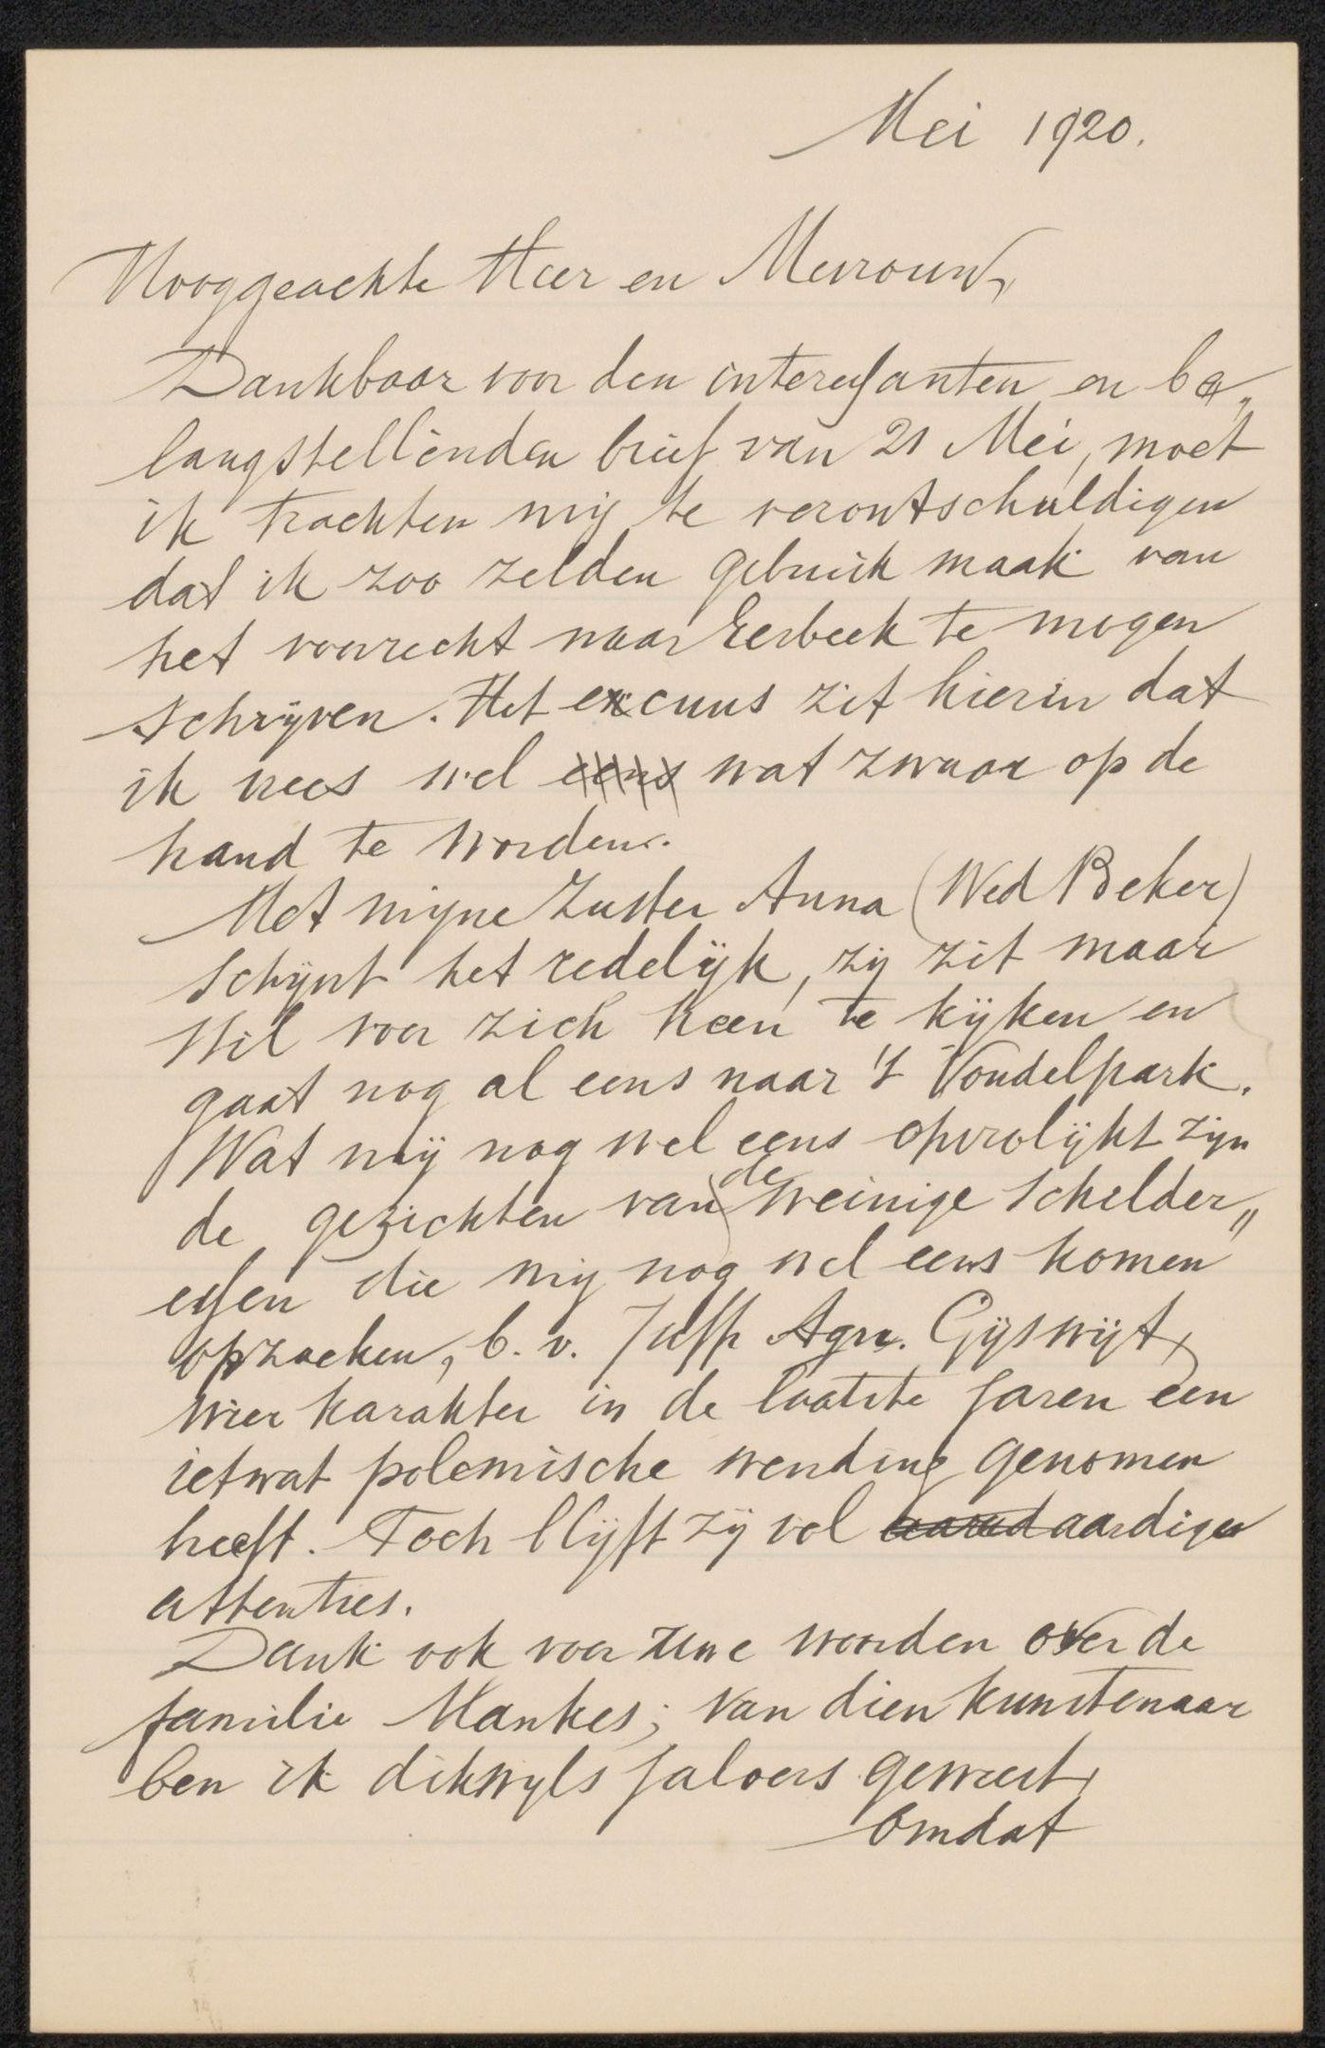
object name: letter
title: Brief aan Max Wilhelm Carl Weber en Anne Antoinette Weber-Van Bosse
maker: august allebé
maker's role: draughtsman, print maker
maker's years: 1838-1927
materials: ink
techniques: pen, writing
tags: anne antoinette weber-van bosse, amsterdam, painter, print maker, draughtsman, agnieta cornelia gijswijt, jan mankes, anne mankes-zernike, diseases